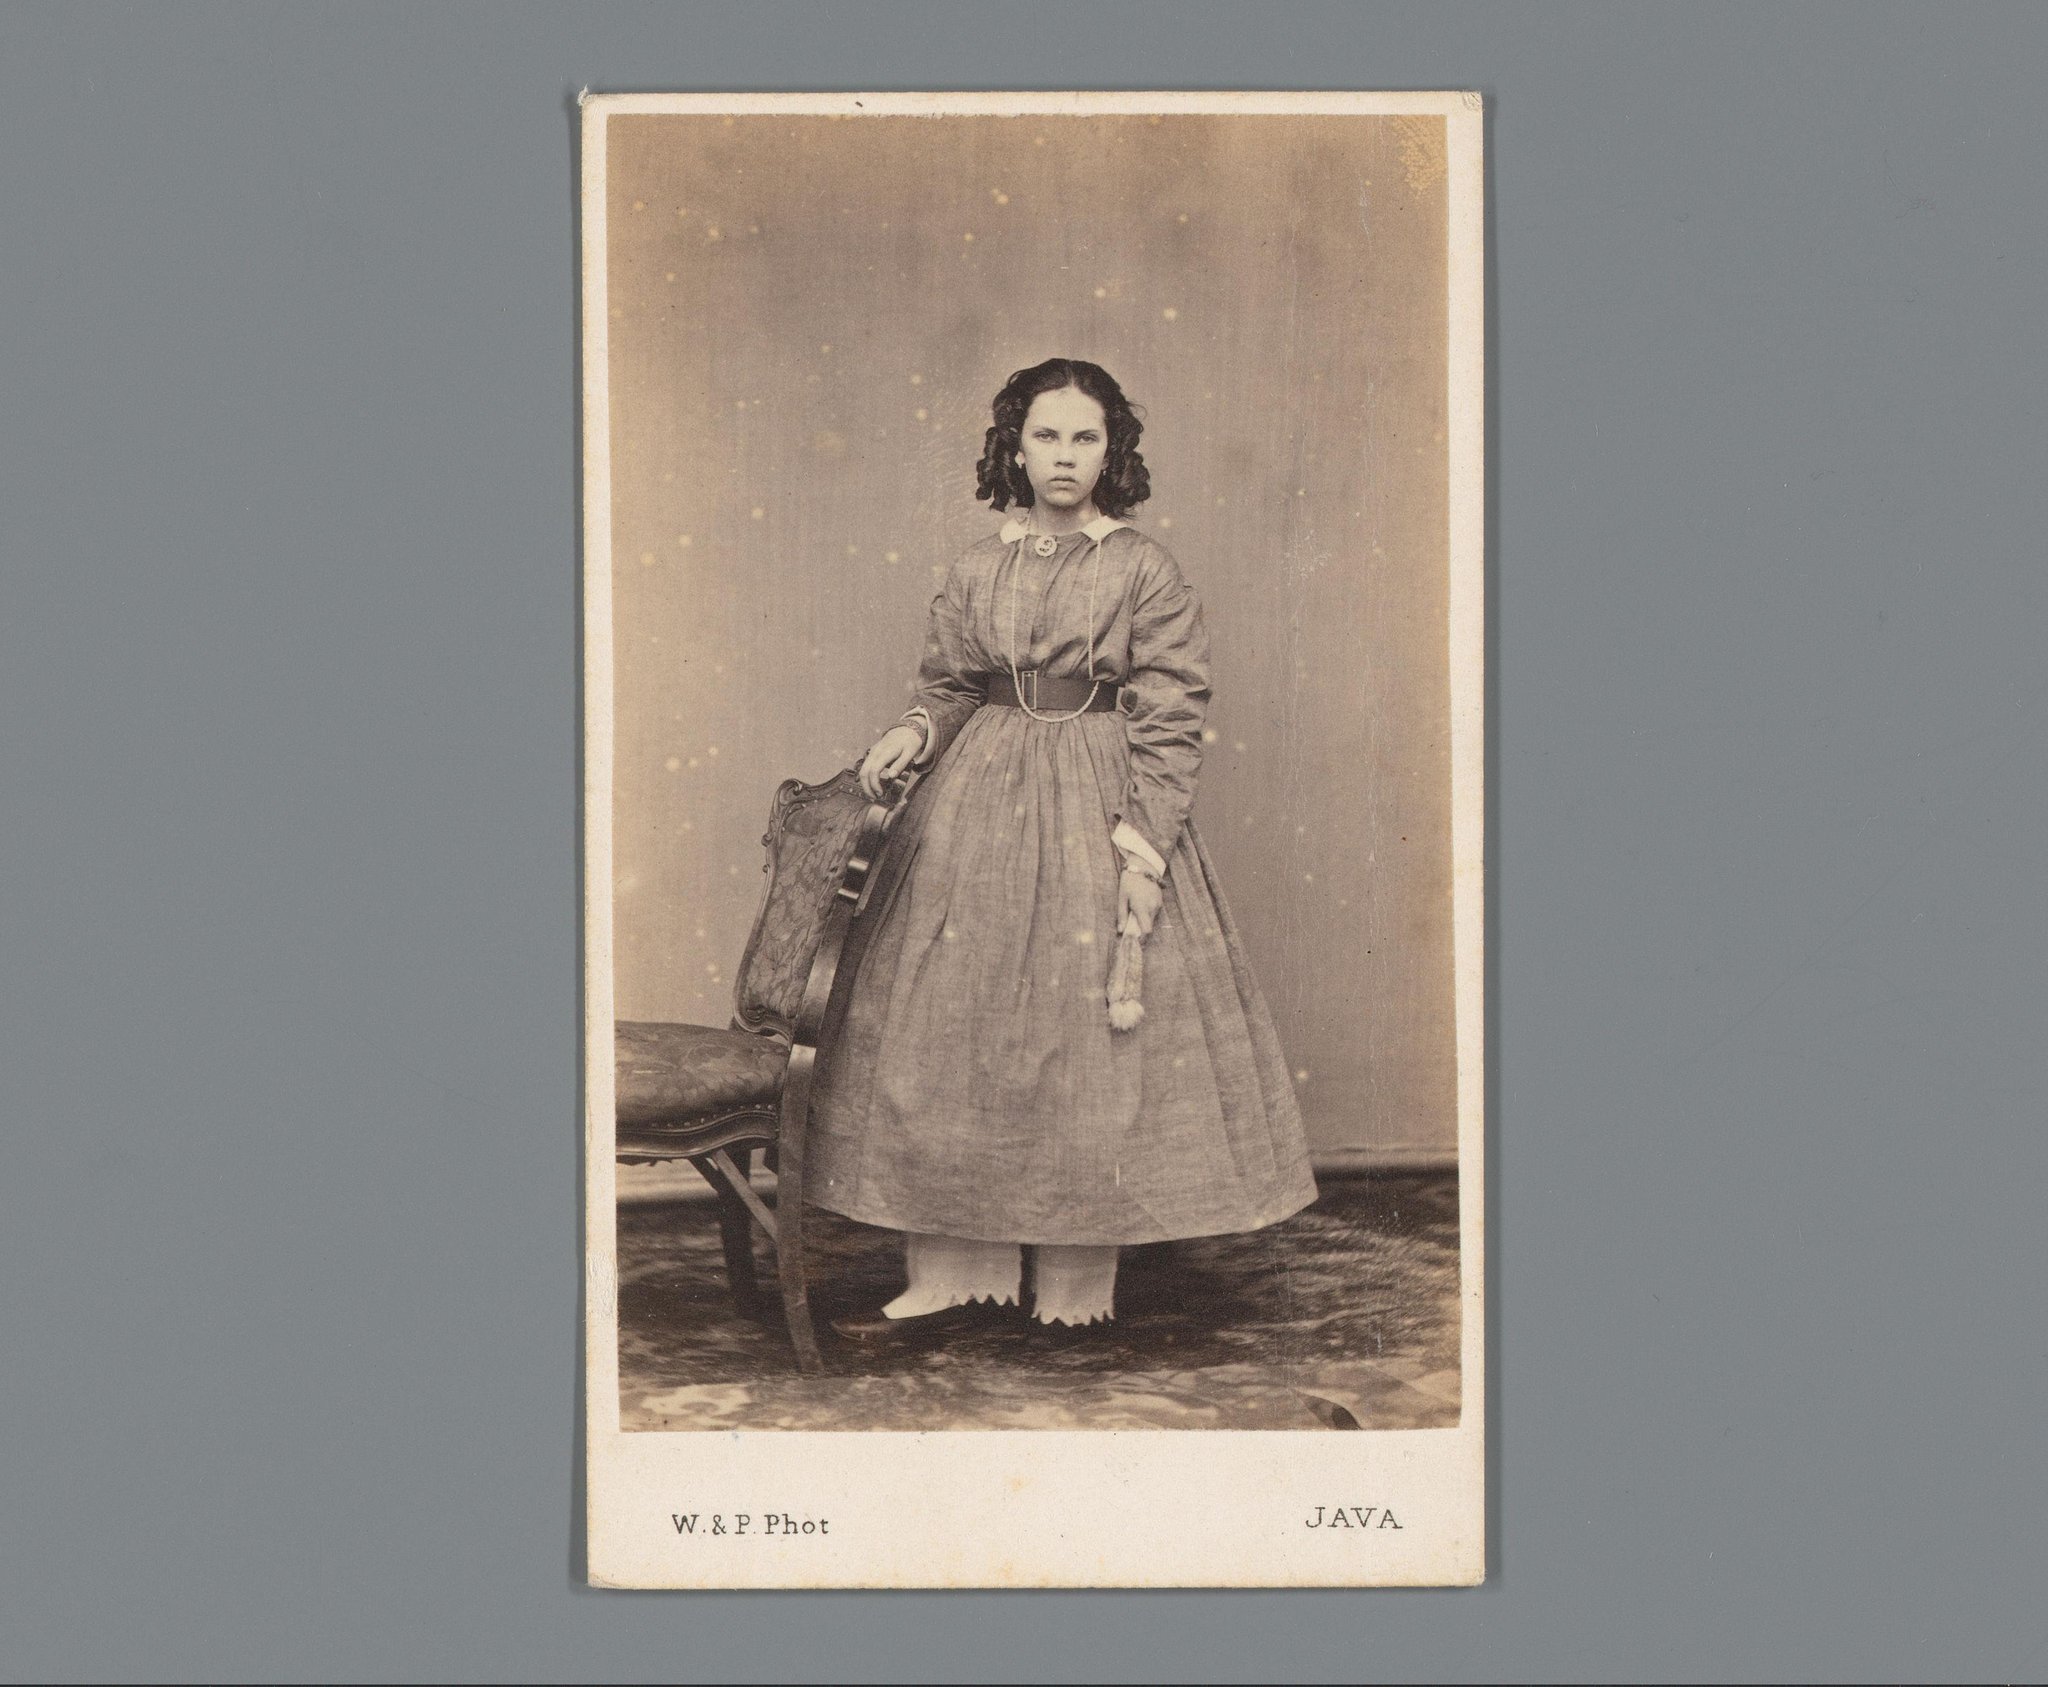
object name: carte de visite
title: Portret van een staande vrouw 'Frederika'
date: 1855-1899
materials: cardboard, photographic support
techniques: albumen print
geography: java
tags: anonymous historical person portrayed - bb - woman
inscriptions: inscription: ‘No. 5 7473 Frederika 12 copies’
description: Portret van een staande jonge vrouw 'Frederika'. Mogelijk een lid van de familie Swellengrebel.